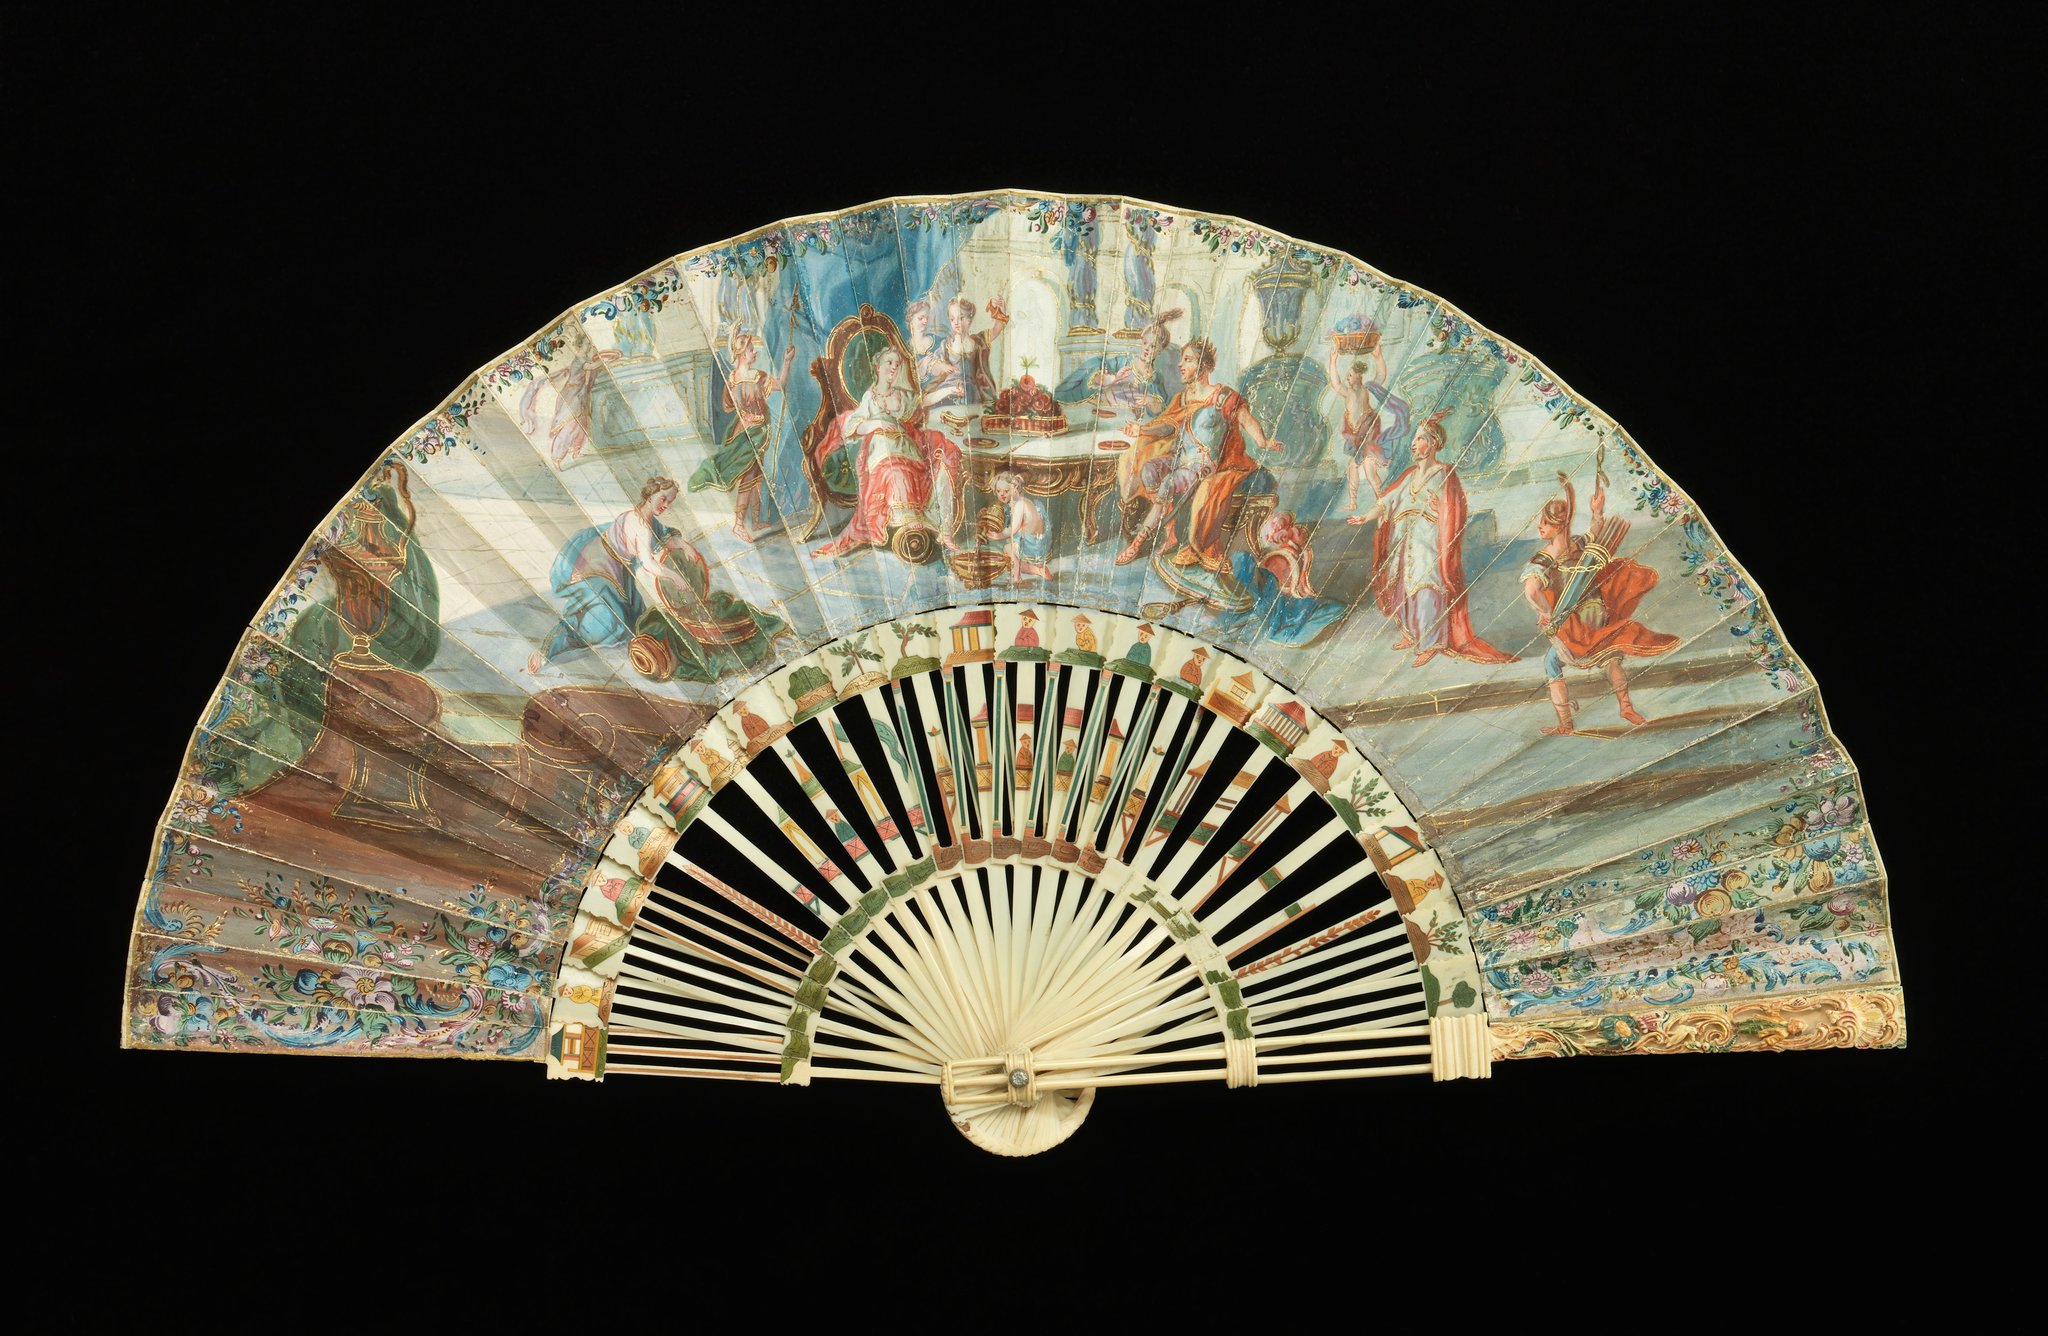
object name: fan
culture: french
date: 1745-1755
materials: gouache, ivory, mother of pearl, paint, paper, wood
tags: men,women,dining